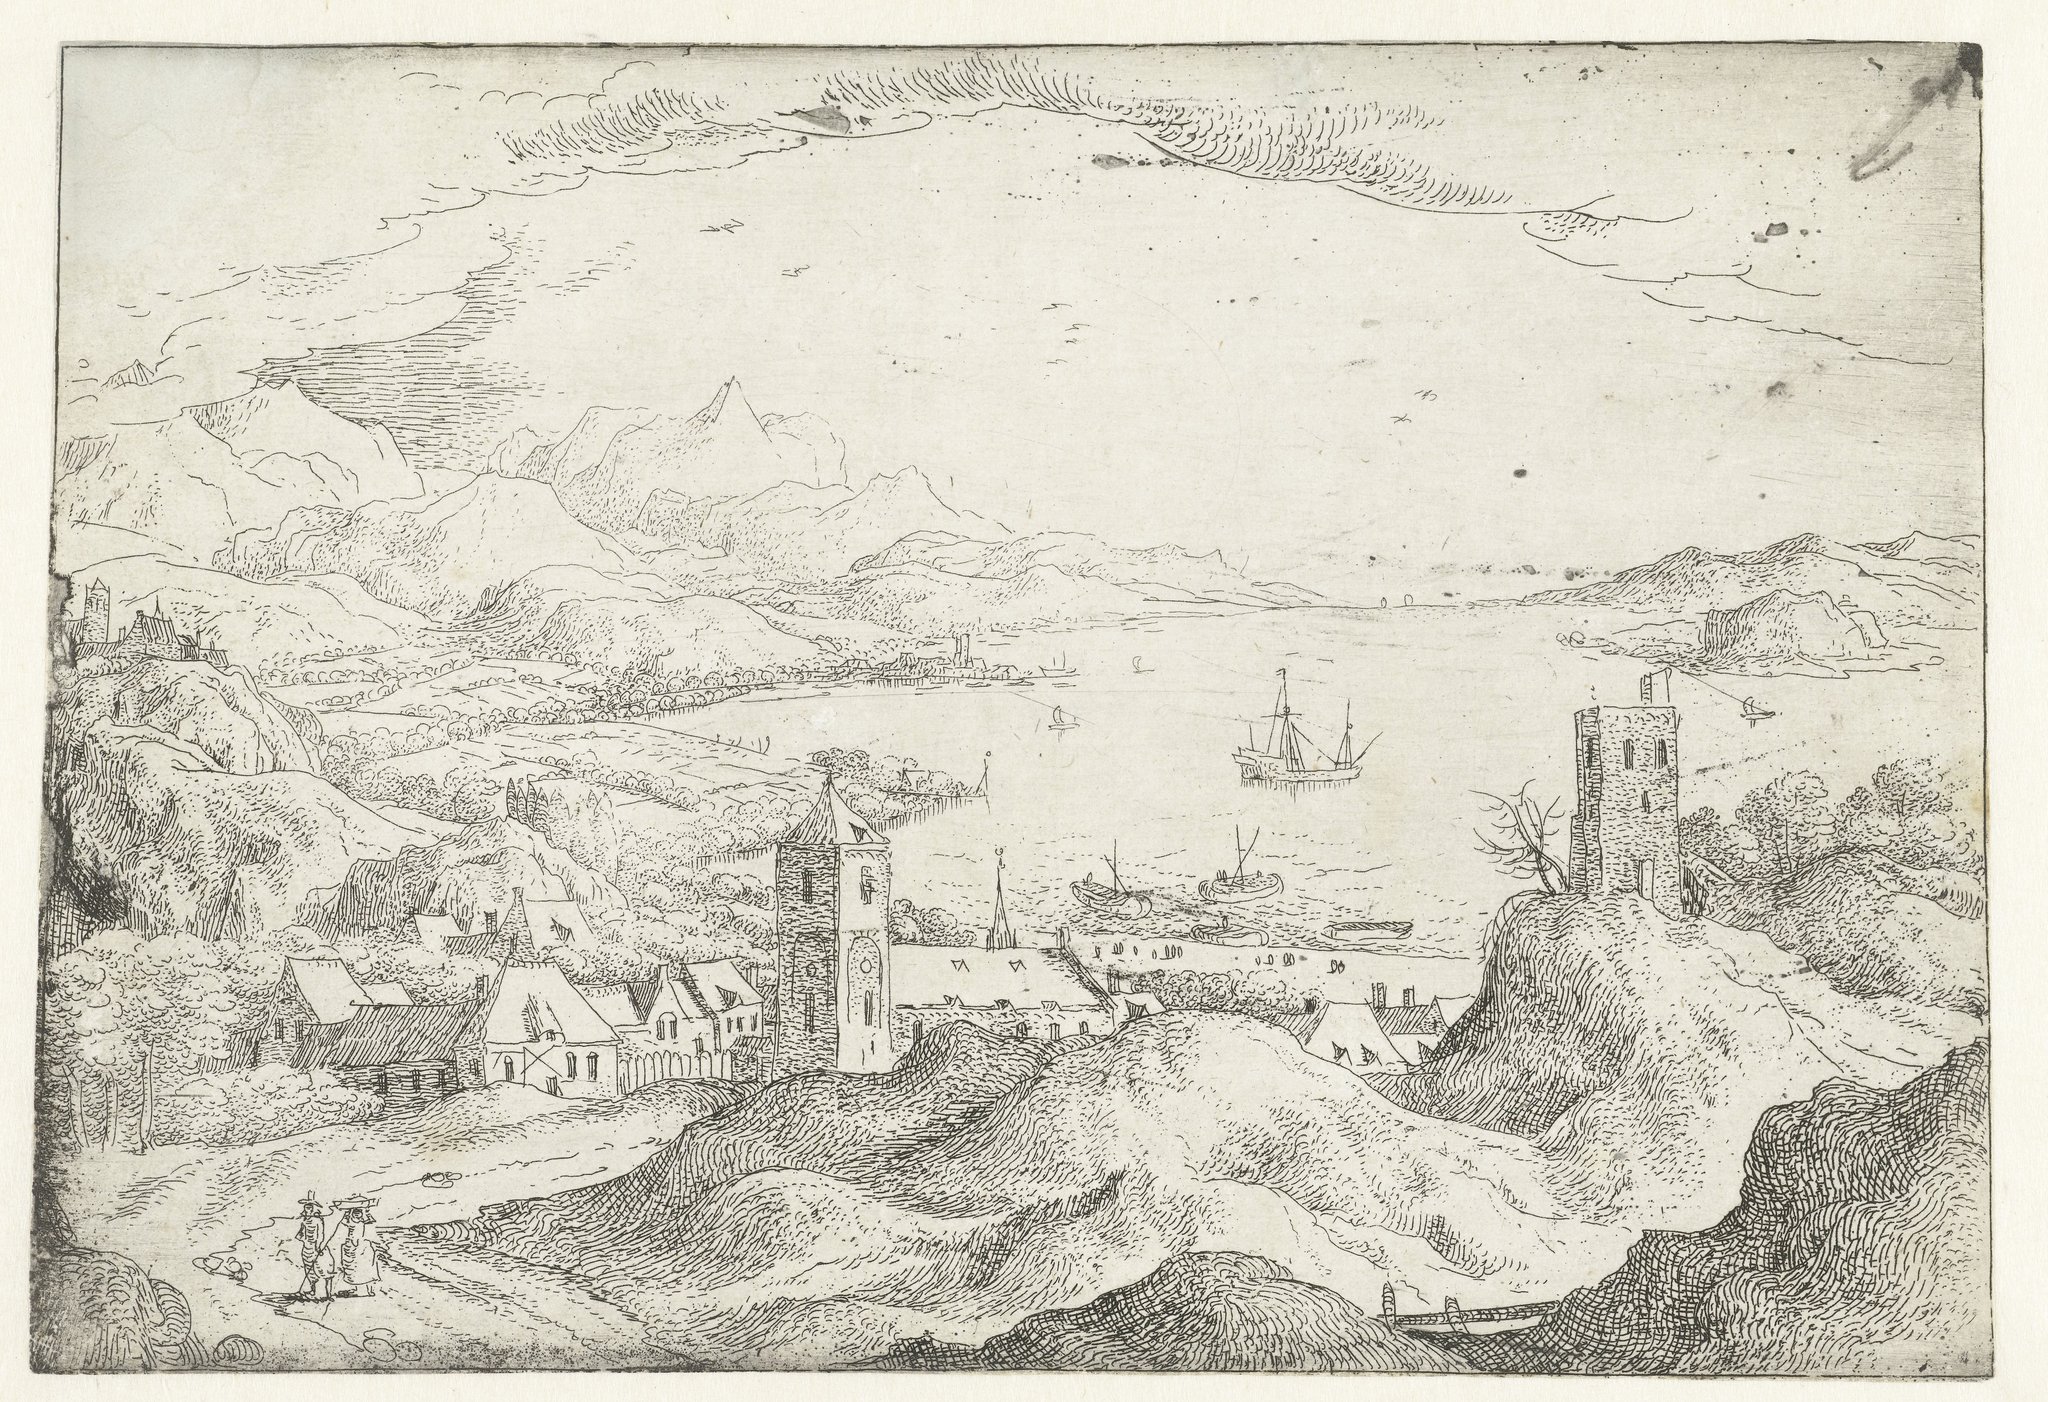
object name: print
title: Zeven landschappen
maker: Anonymous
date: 1550-1580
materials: paper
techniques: etching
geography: southern netherlands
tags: river, village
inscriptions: collector's mark: Lugt 2228a, collector's mark: Lugt 2760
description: Landschap met een brede rivier in heuvelachtig landschap. Boten in het water. Op de voorgrond een dorp met kerk en rechts een toren. Twee lopende vrouwen op het pad op de voorgrond.